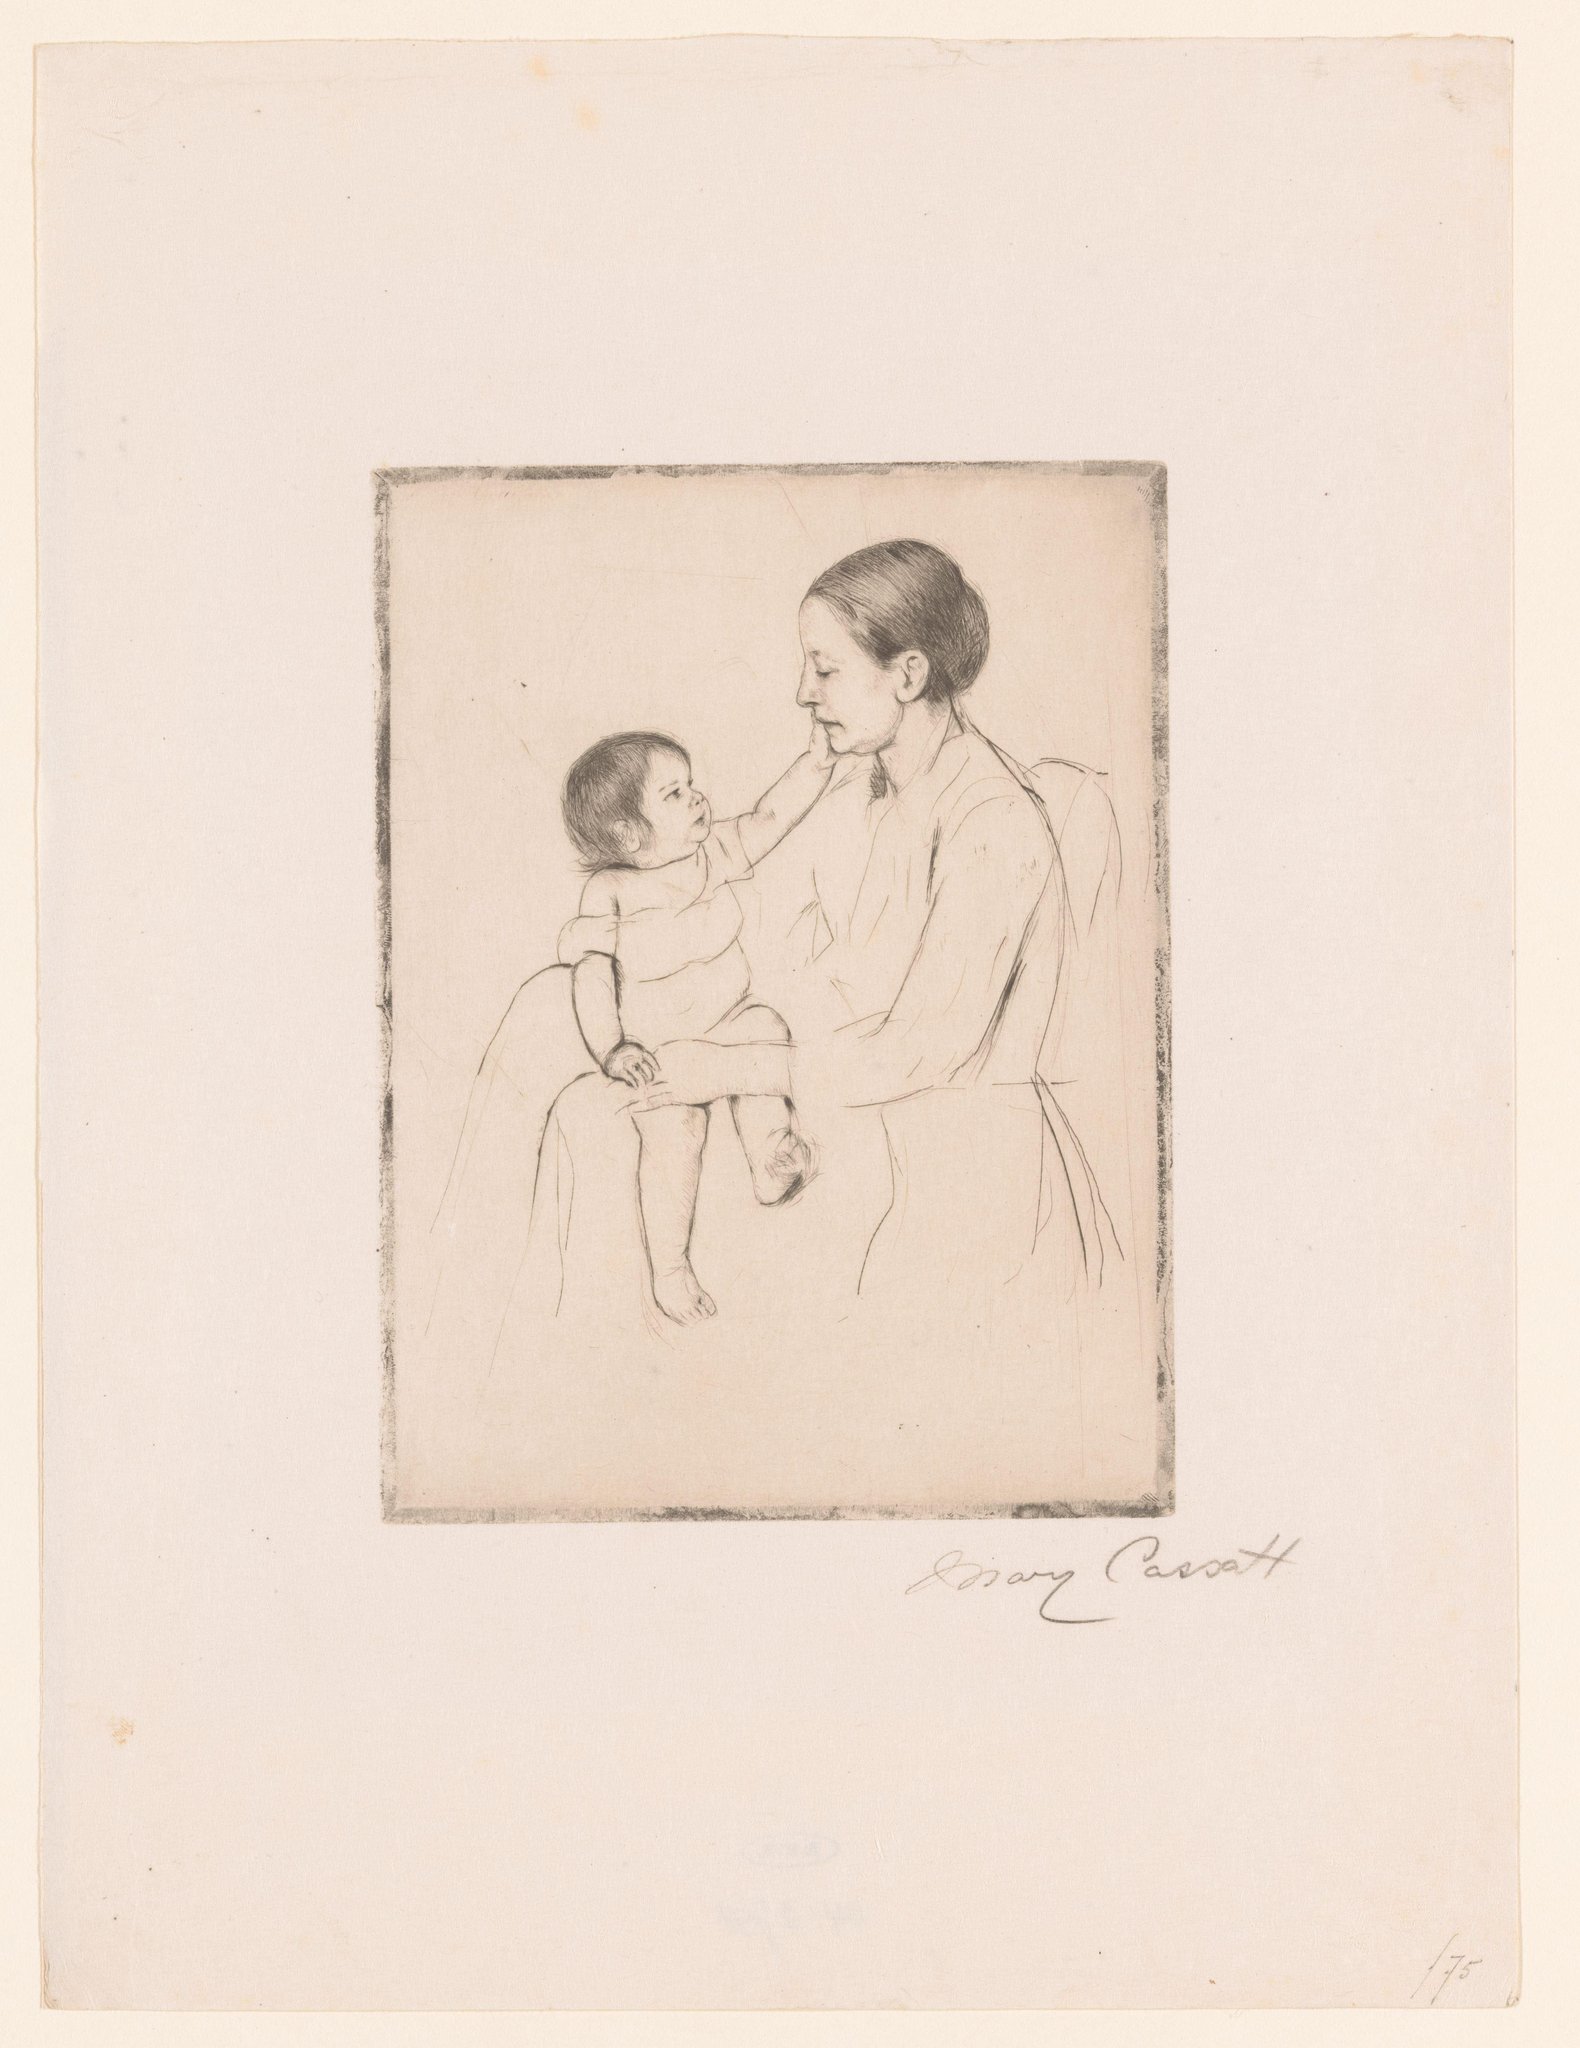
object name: print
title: The caress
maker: mary cassatt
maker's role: print maker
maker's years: 1844-1926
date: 1891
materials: paper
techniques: drypoint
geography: france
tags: mother and baby or young child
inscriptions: signature: ‘Mary Cassatt’, collector's mark: Lugt 2228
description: Moeder met kind zittend op haar schoot, het kind raakt met zijn linkerhand het gezicht van de vrouw.